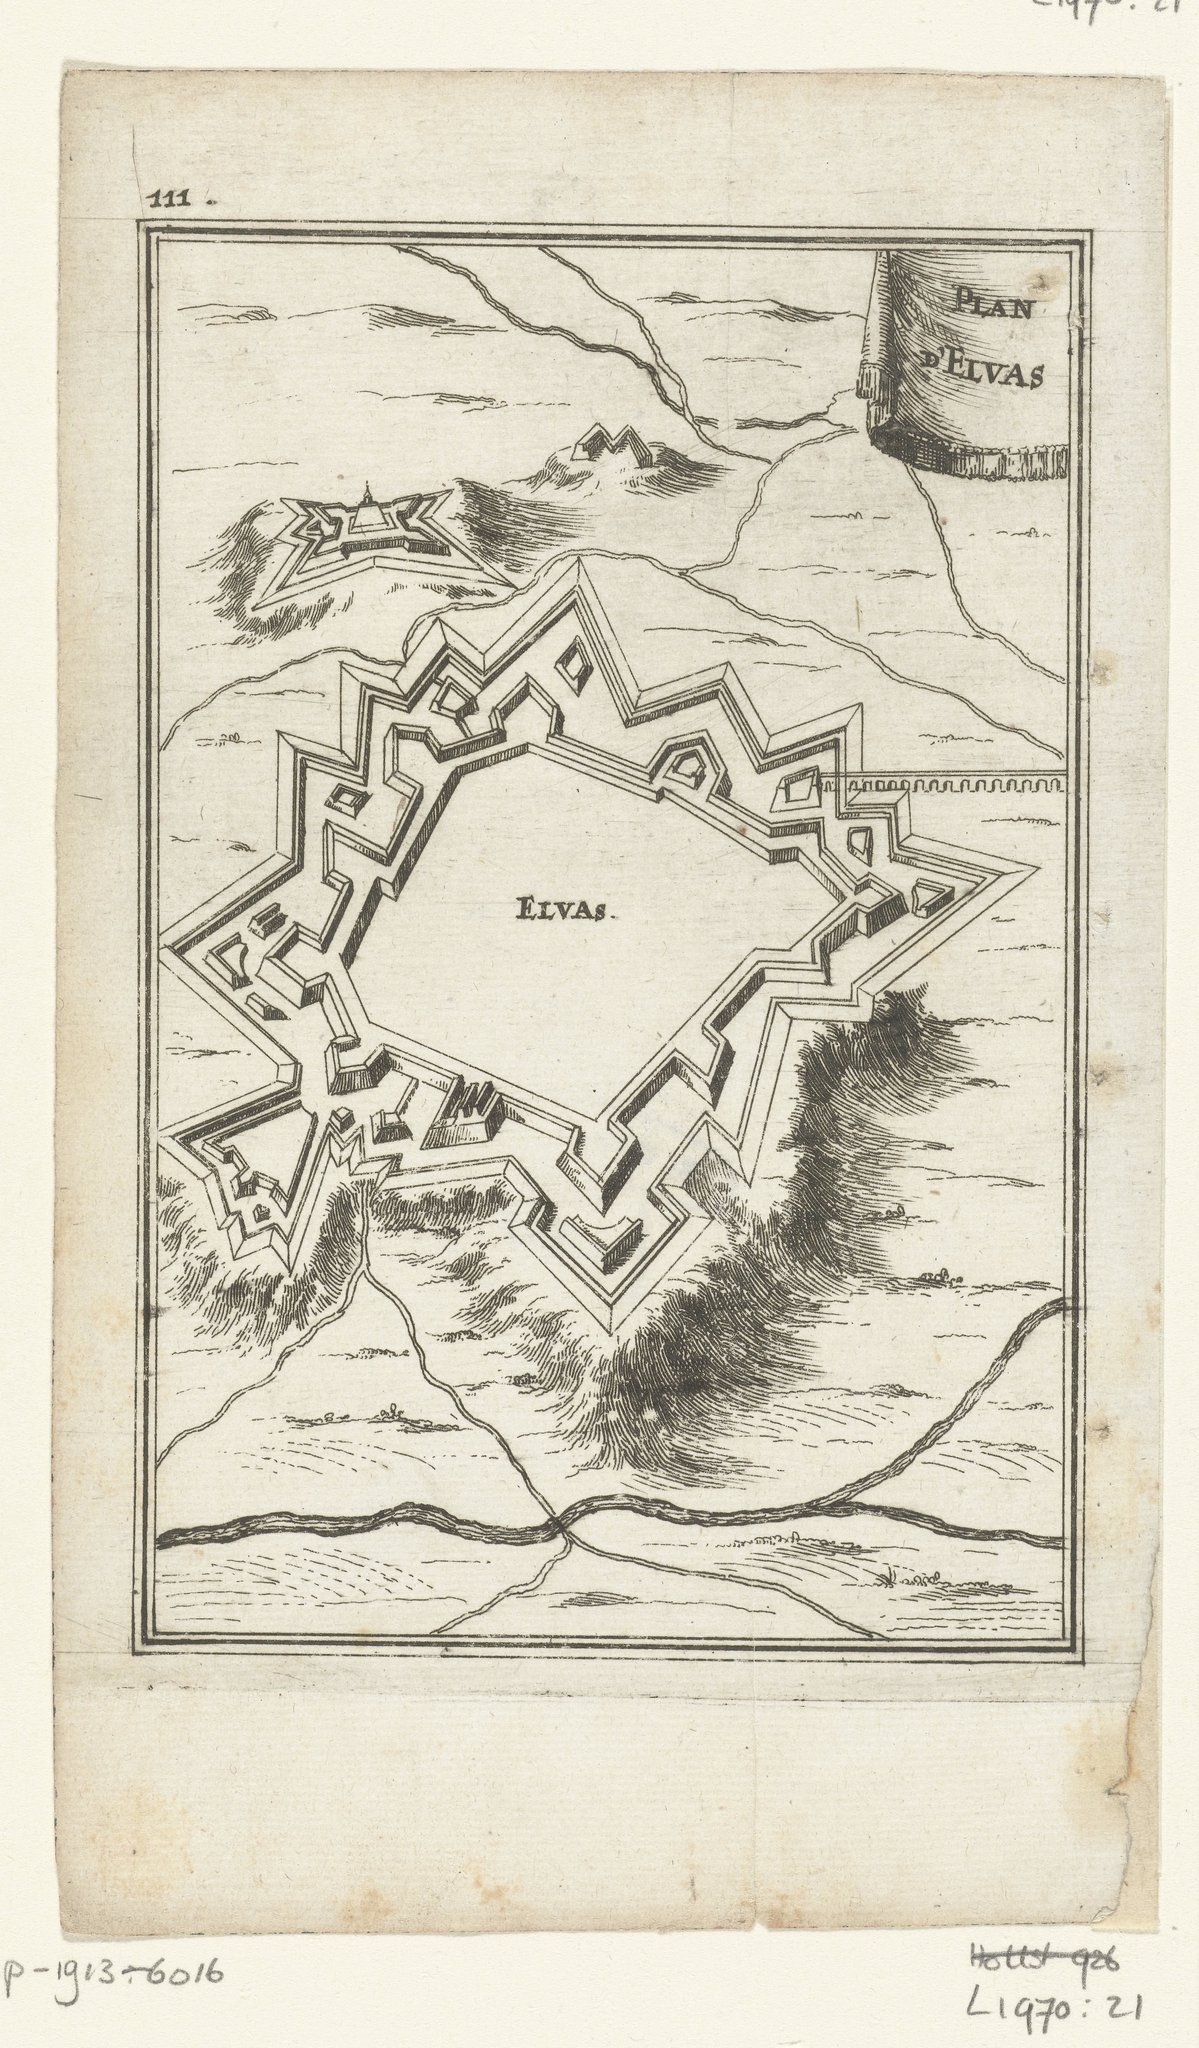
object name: print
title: Illustratie voor 'Den Arbeid van Mars' van Allain Manesson Mallet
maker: romeyn de hooghe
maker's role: draughtsman, goldsmith, painter, print maker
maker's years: 1645-1708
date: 1672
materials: paper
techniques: engraving, etching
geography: amsterdam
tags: city-view in general; 'veduta', fortifications, military engineering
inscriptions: collector's mark: Lugt 2228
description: Illustratie voor: Allain Manesson Mallet, 'Den Arbeid van Mars' (3 delen, Amsterdam: Jacob van Meurs of Amsterdam: Jacob van Meurs en Johannes (I) Janssonius van Waesberge, 1672). Klinkert, C.